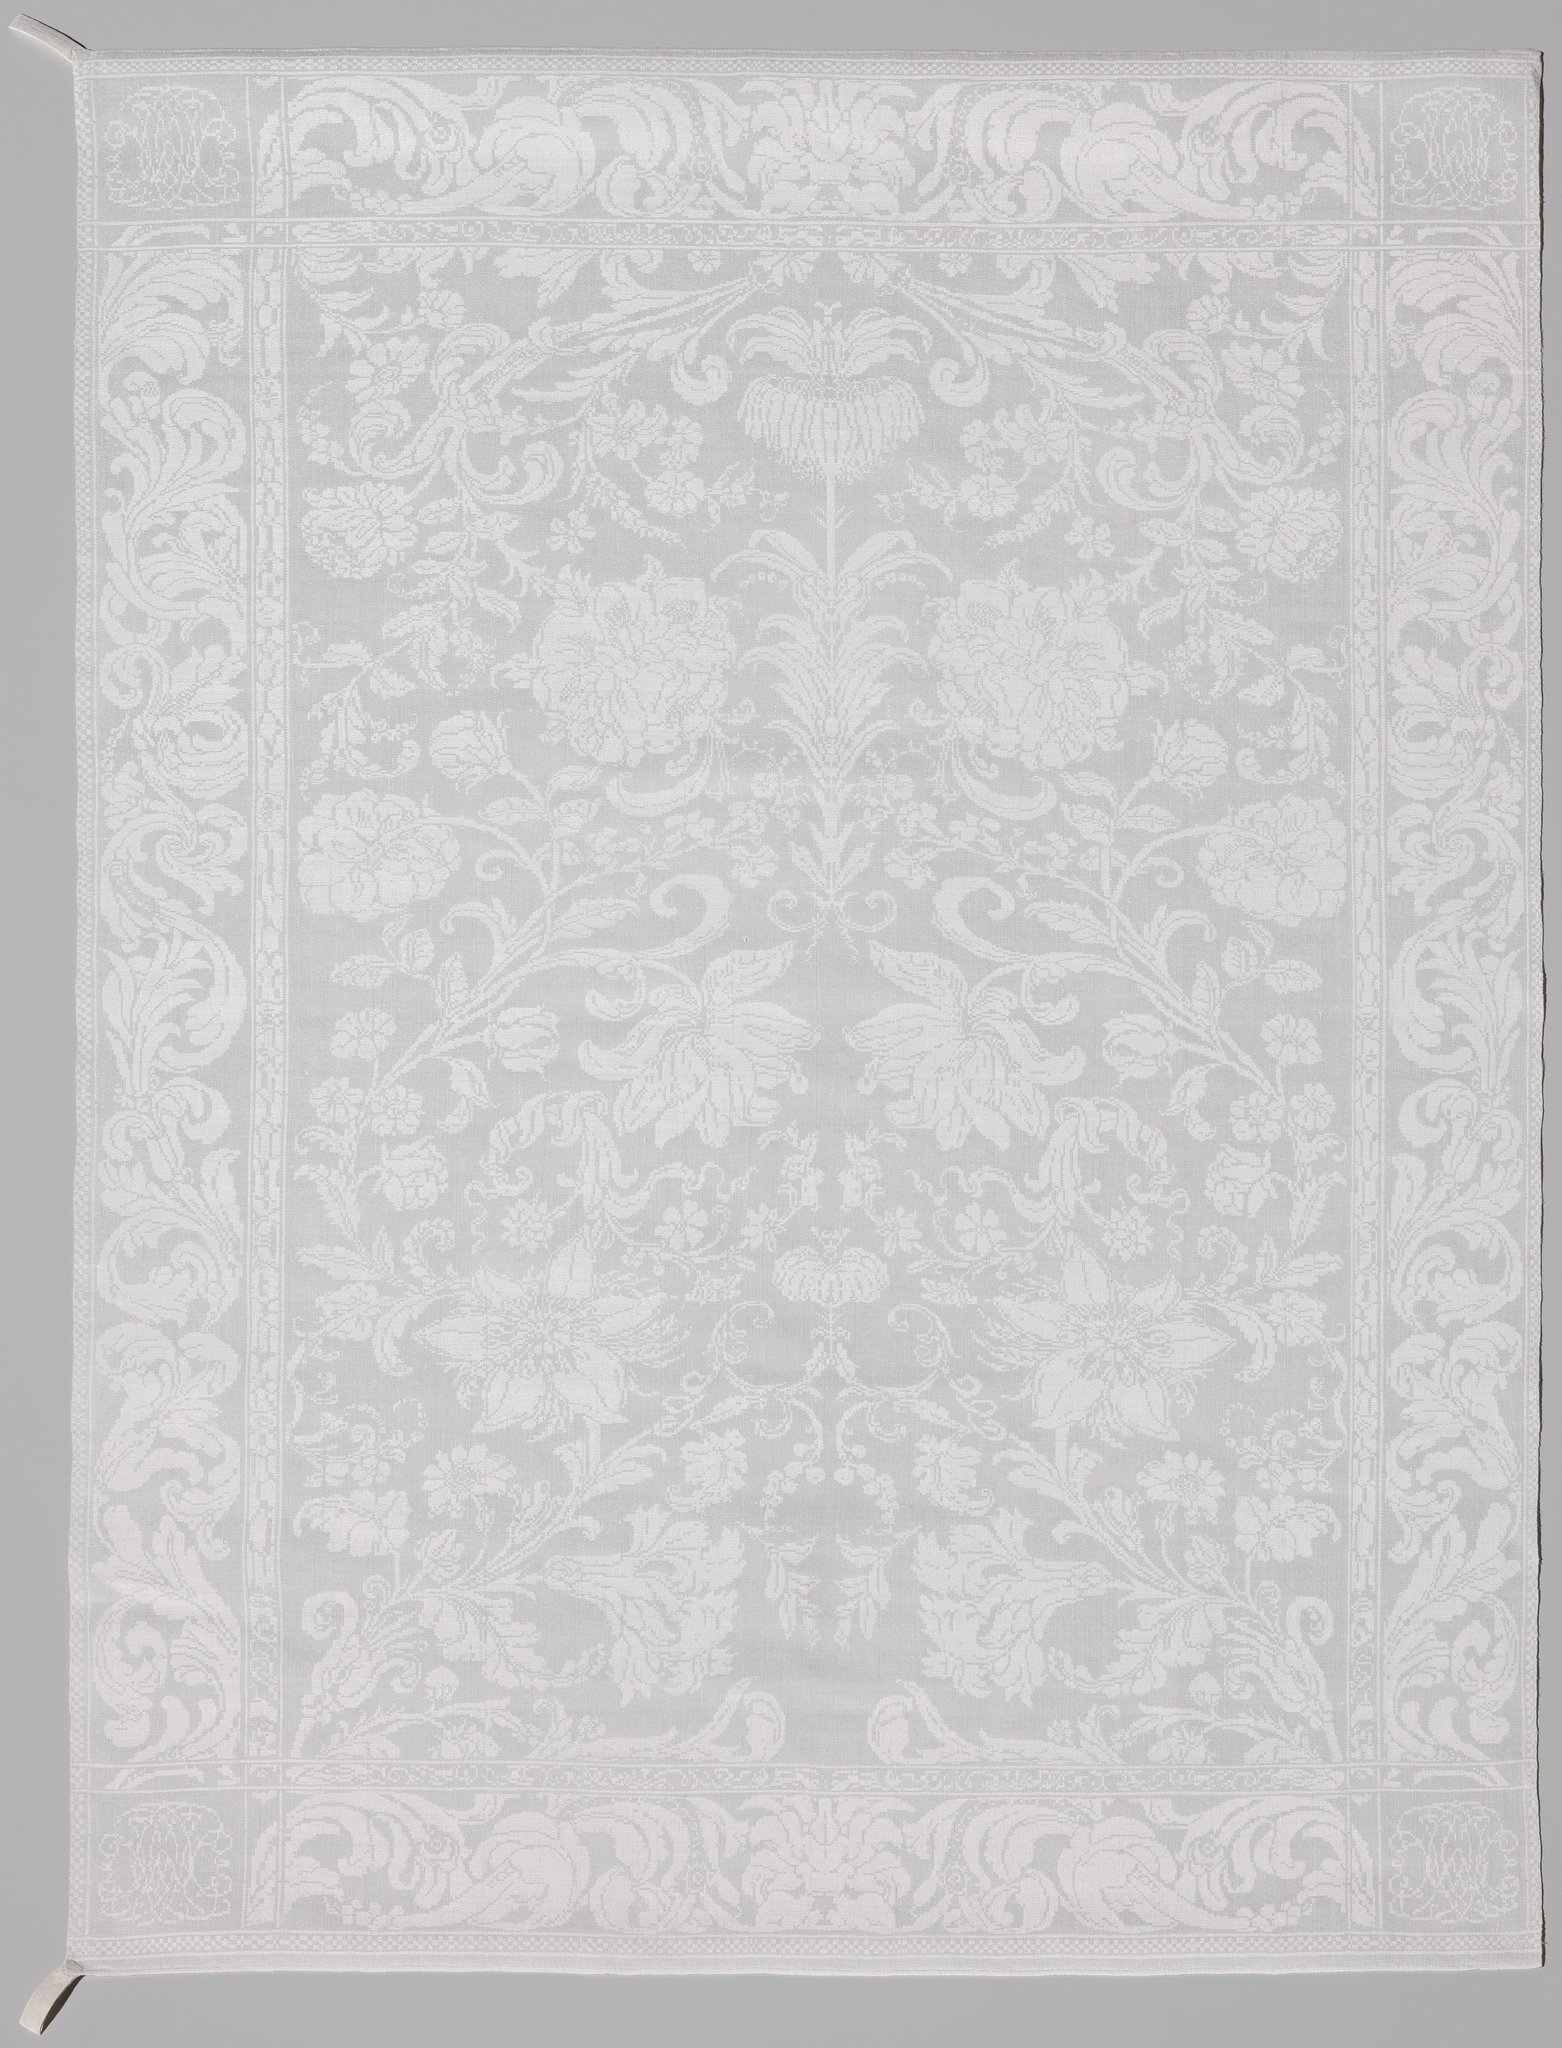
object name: napkin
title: Servet met patroon van takken met keizerskroon (fritillaria imperialis) en met ingeweven monogram in de hoeken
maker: Anonymous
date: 1680-1690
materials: linen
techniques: damask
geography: northern netherlands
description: Wit linnen damasten servet met takken met keizerskroon (latijn: fritillaria imperialis). Vier randen met bladranken. Ingeweven monogram in de hoeken. Gemerkt met bindgatletter "AK".